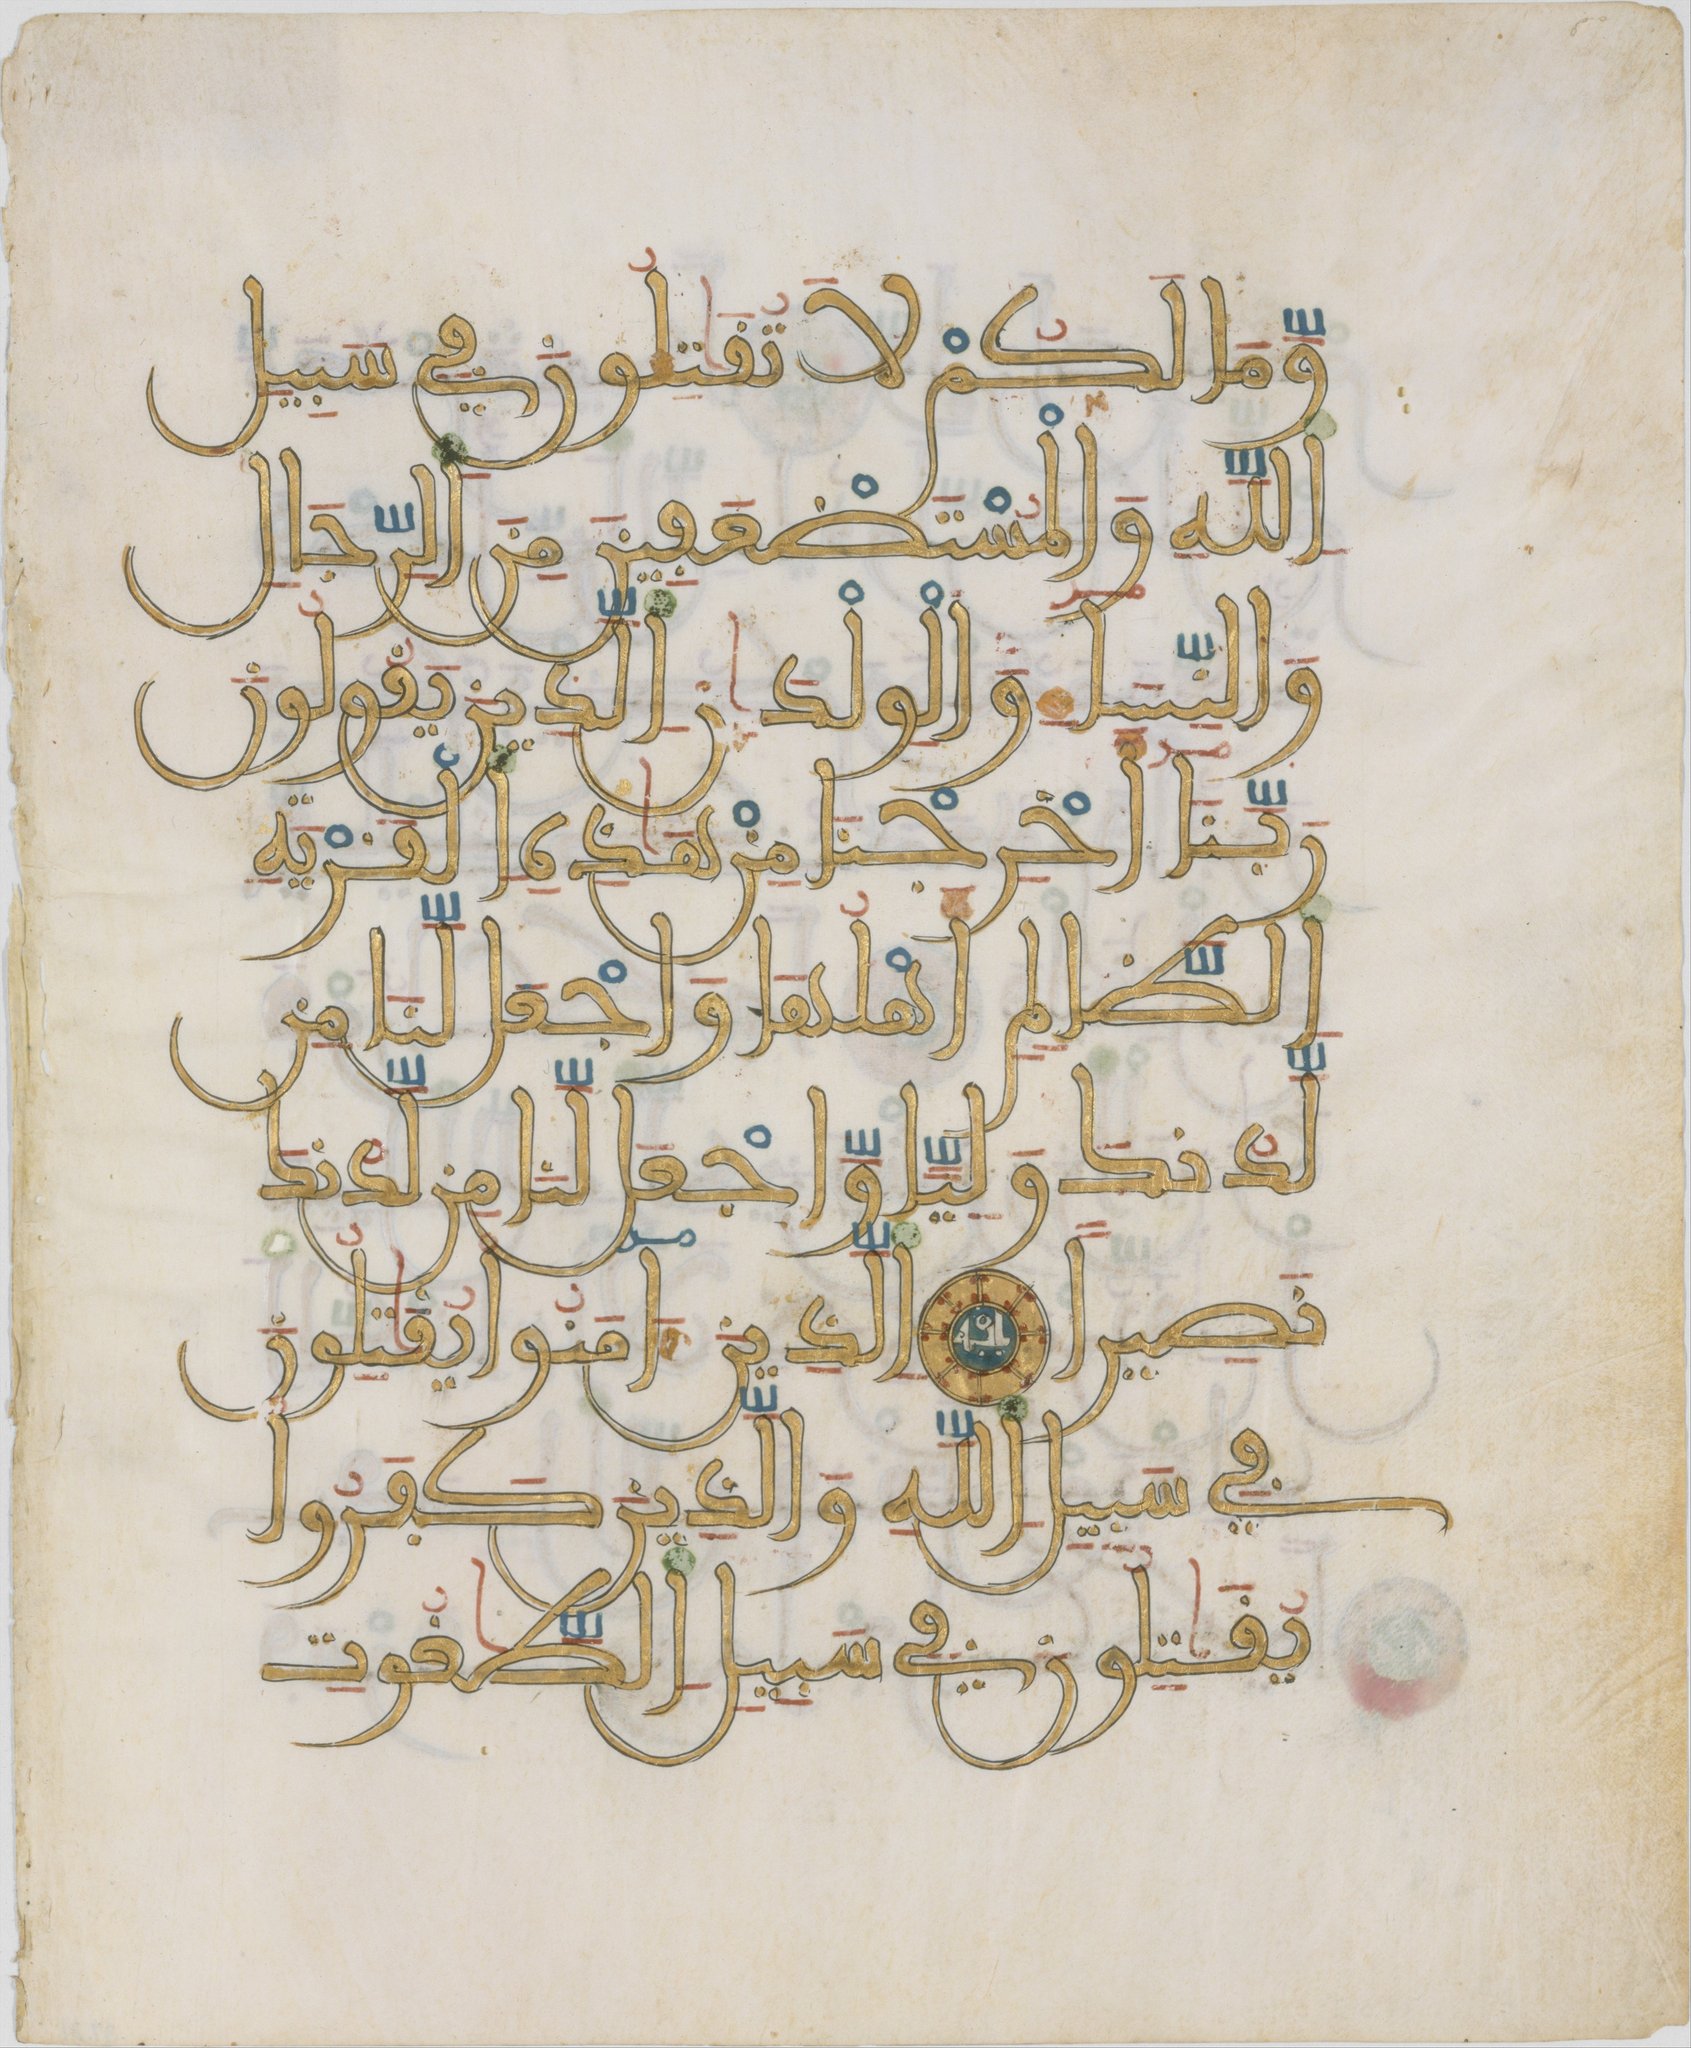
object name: folio from a non illustrated manuscript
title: Folio from a Qur'an Manuscript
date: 1250-1300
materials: gold, ink, parchment, watercolor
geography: north africa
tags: qur'an,calligraphy